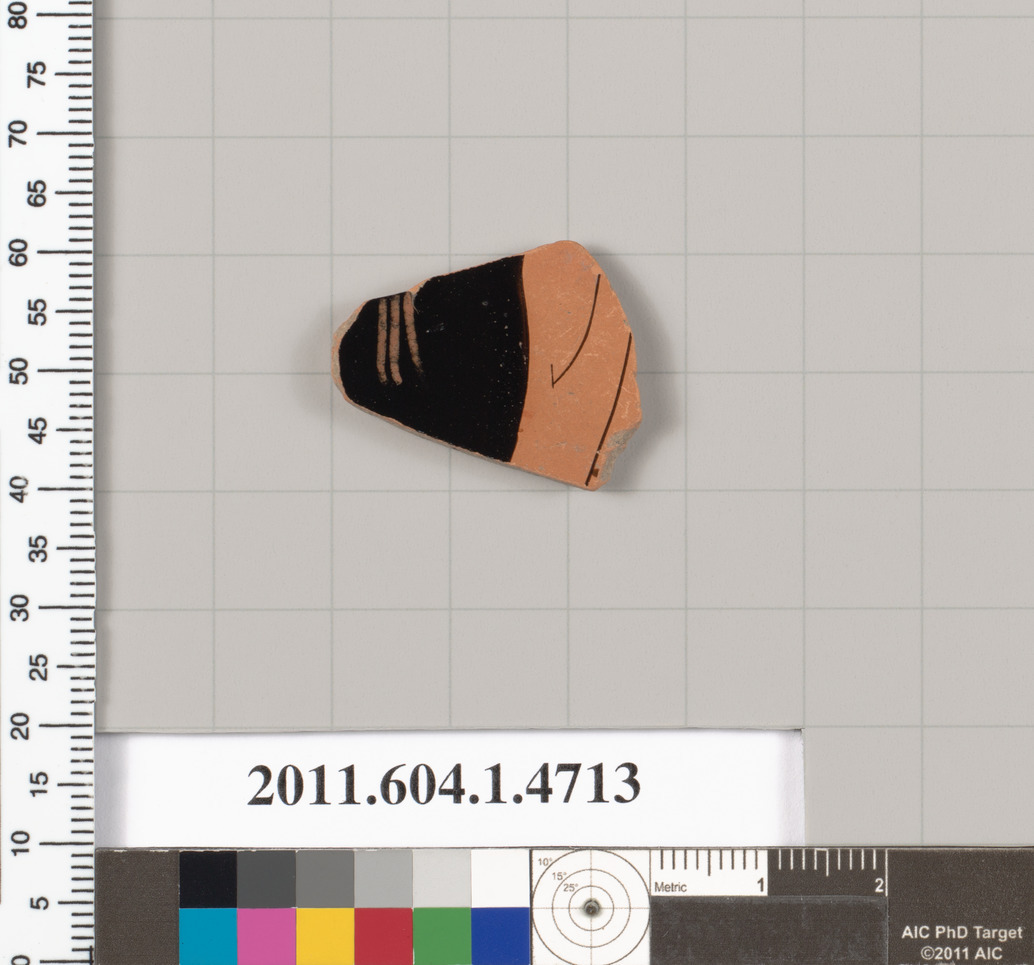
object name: kylix fragment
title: Terracotta fragment of a kylix (drinking cup)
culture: greek, attic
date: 475-451 BCE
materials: terracotta